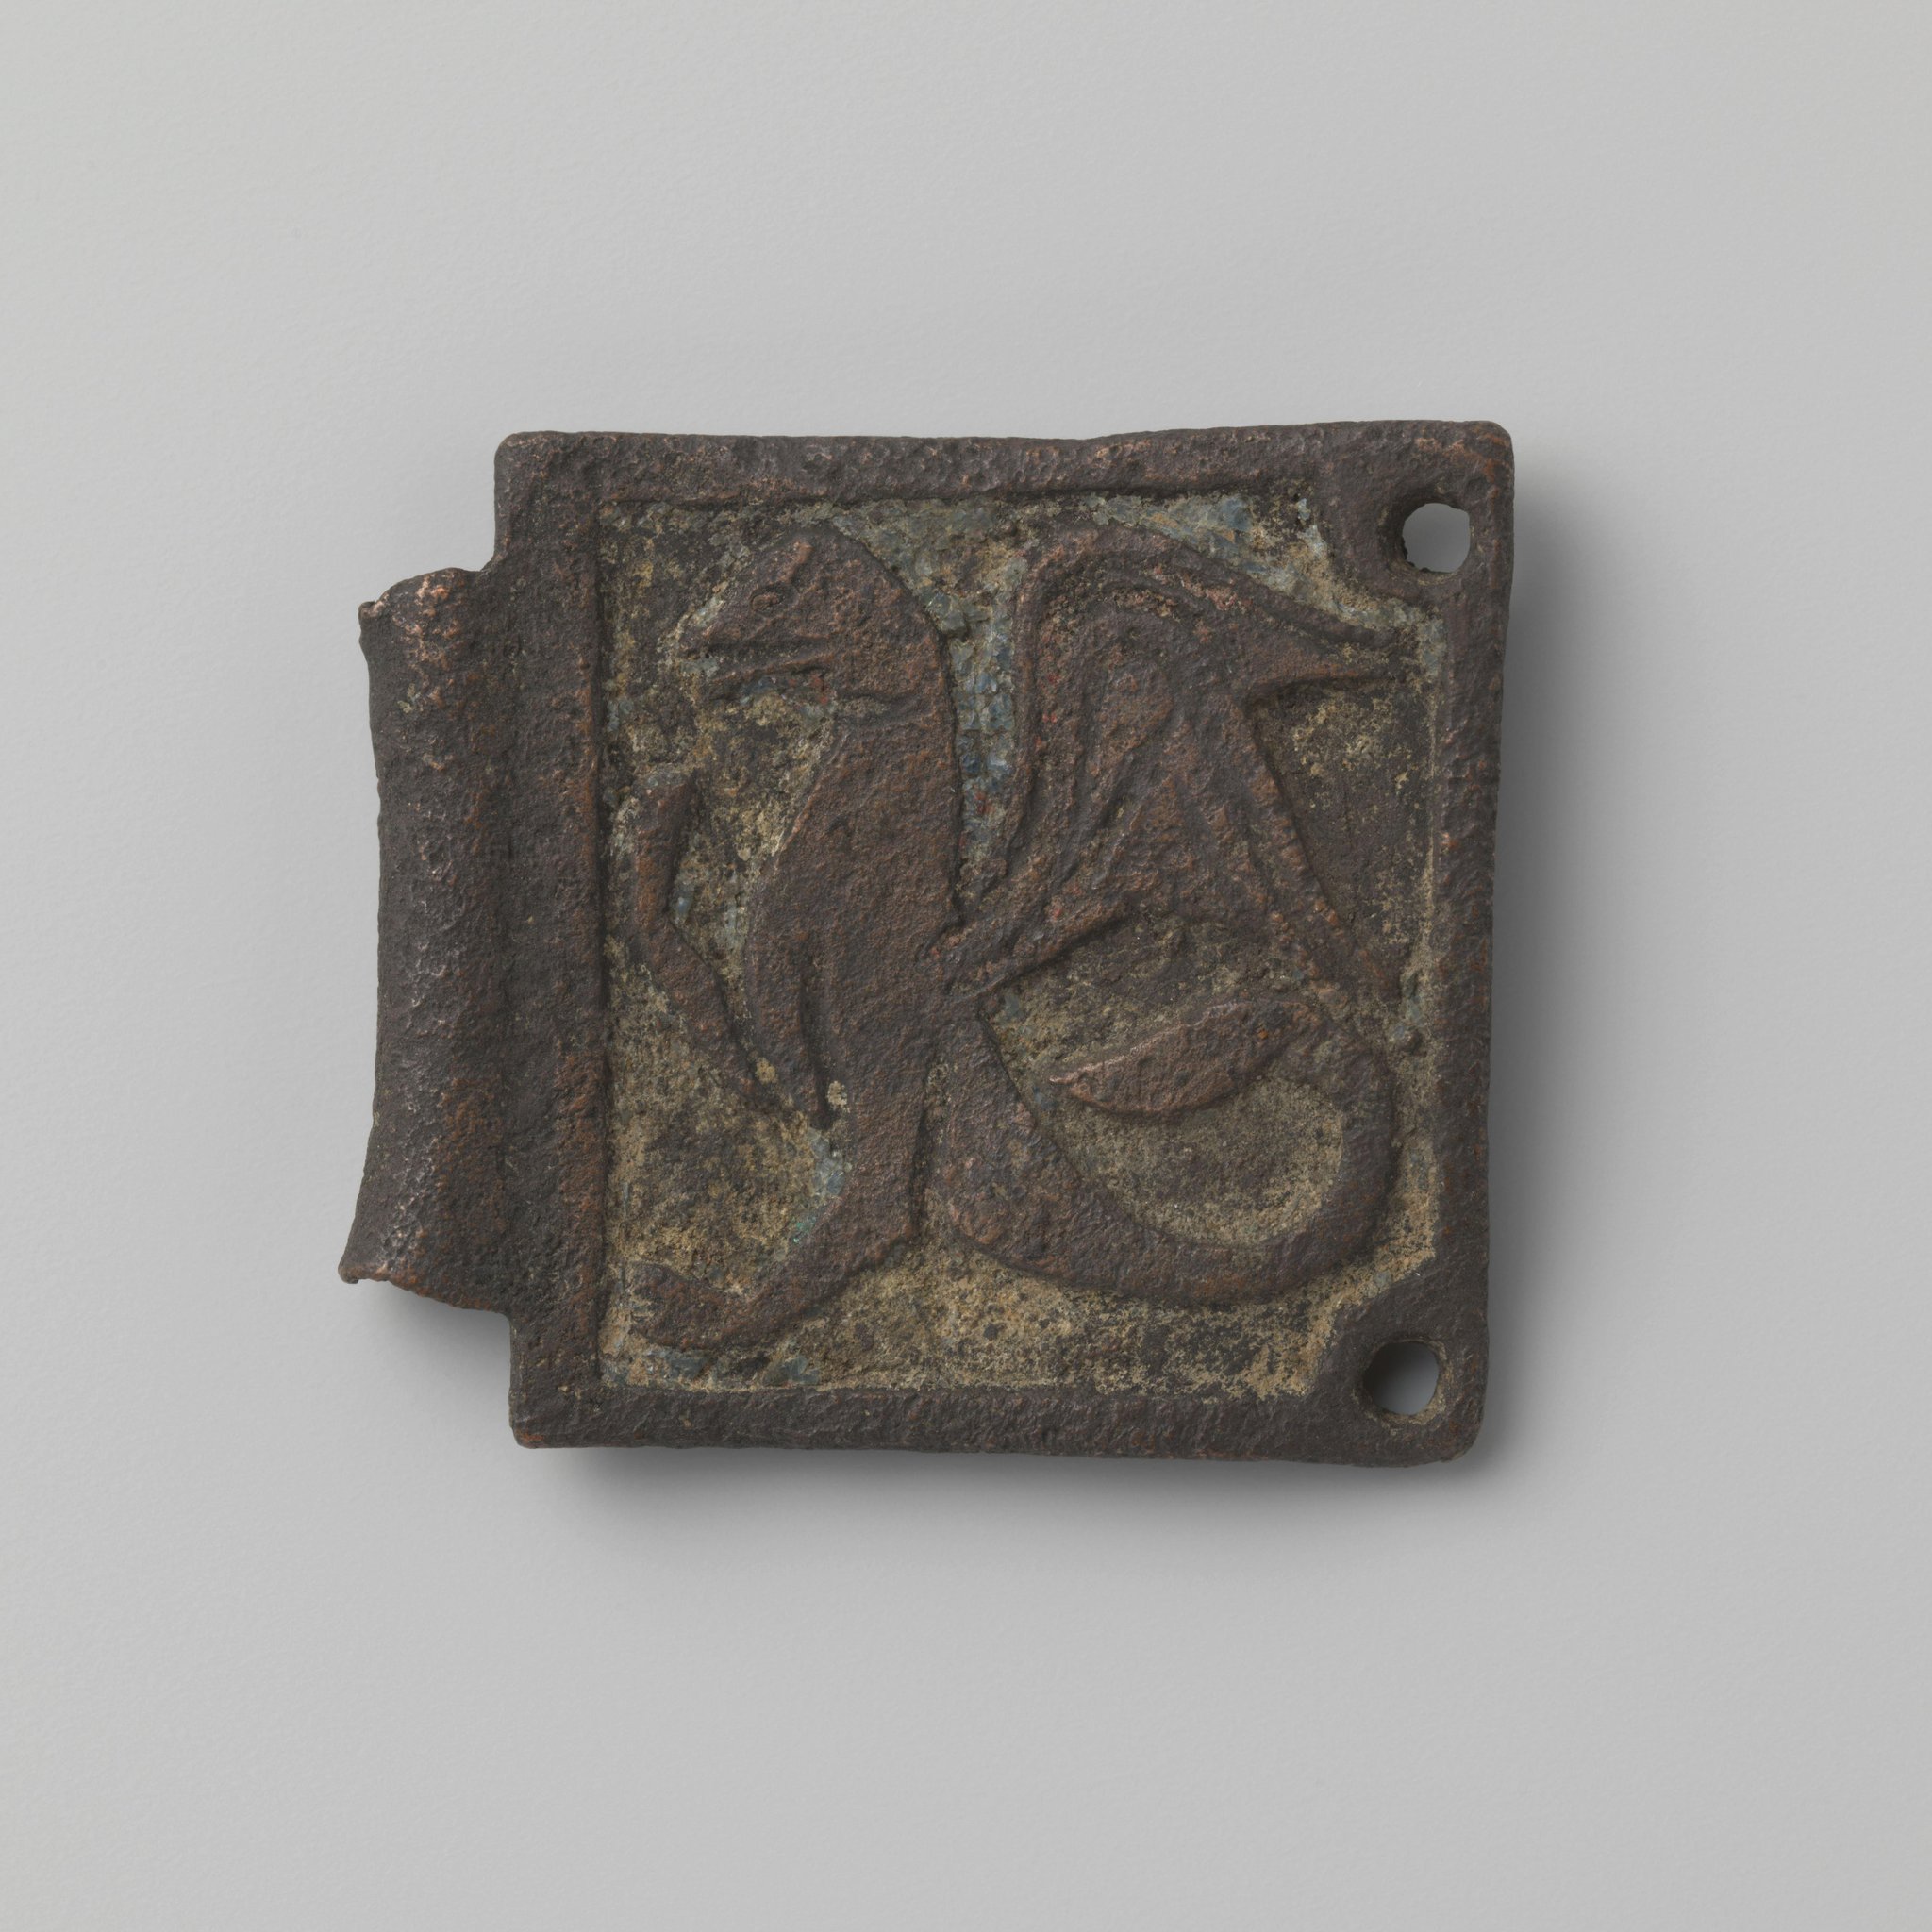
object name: fragment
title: Koperen plaat van een gesp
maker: Anonymous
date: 1200-1300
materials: copper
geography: france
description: Koperen plaatje van een gesp waarop de vorm van een vogel is uitgespaard.